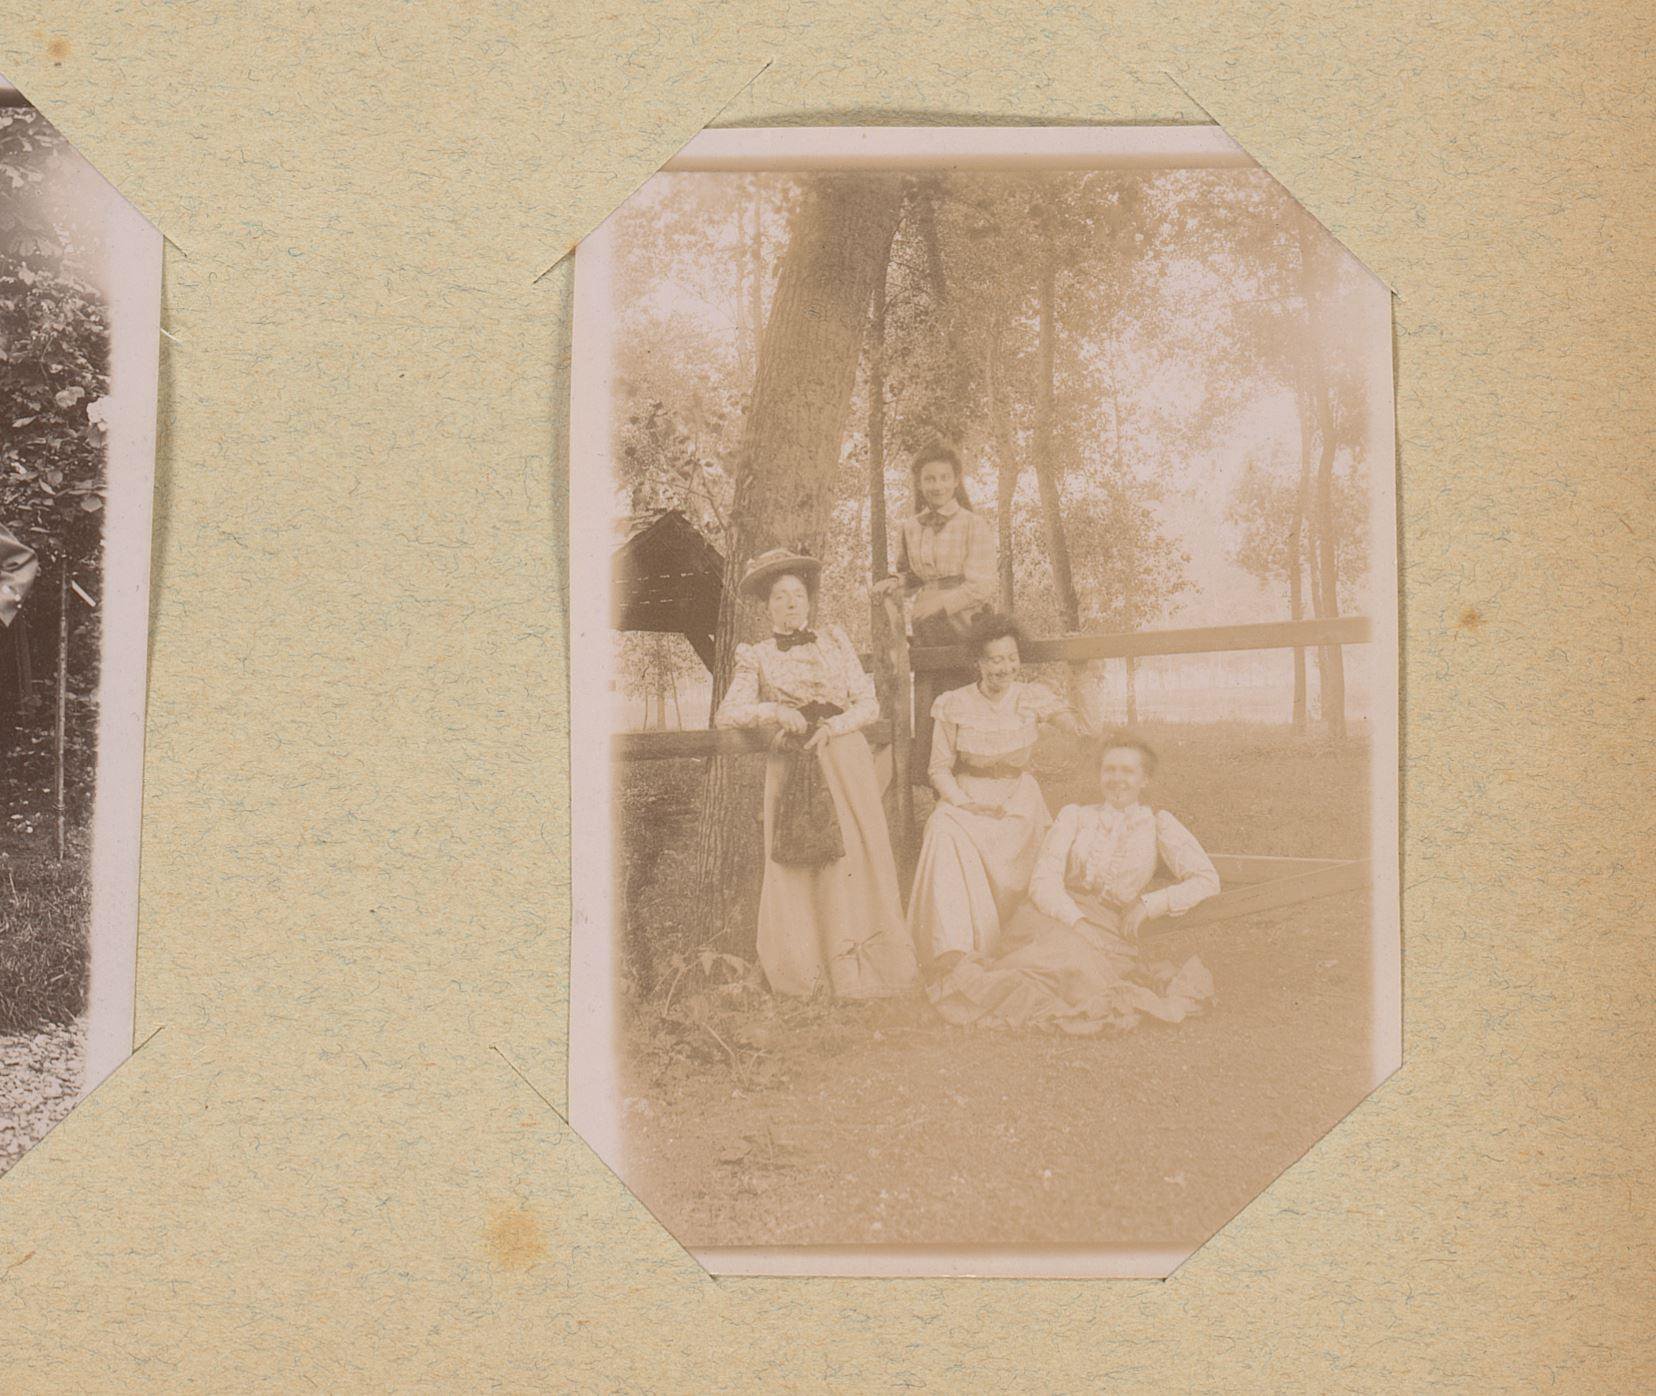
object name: album leaf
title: Groepsportret van vier jonge vrouwen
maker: Anonymous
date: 1897-1900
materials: paper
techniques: gelatin silver print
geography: france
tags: adolescent, young woman, maiden, anonymous historical persons portrayed in a group, in a group-portrait - bb - woman, france